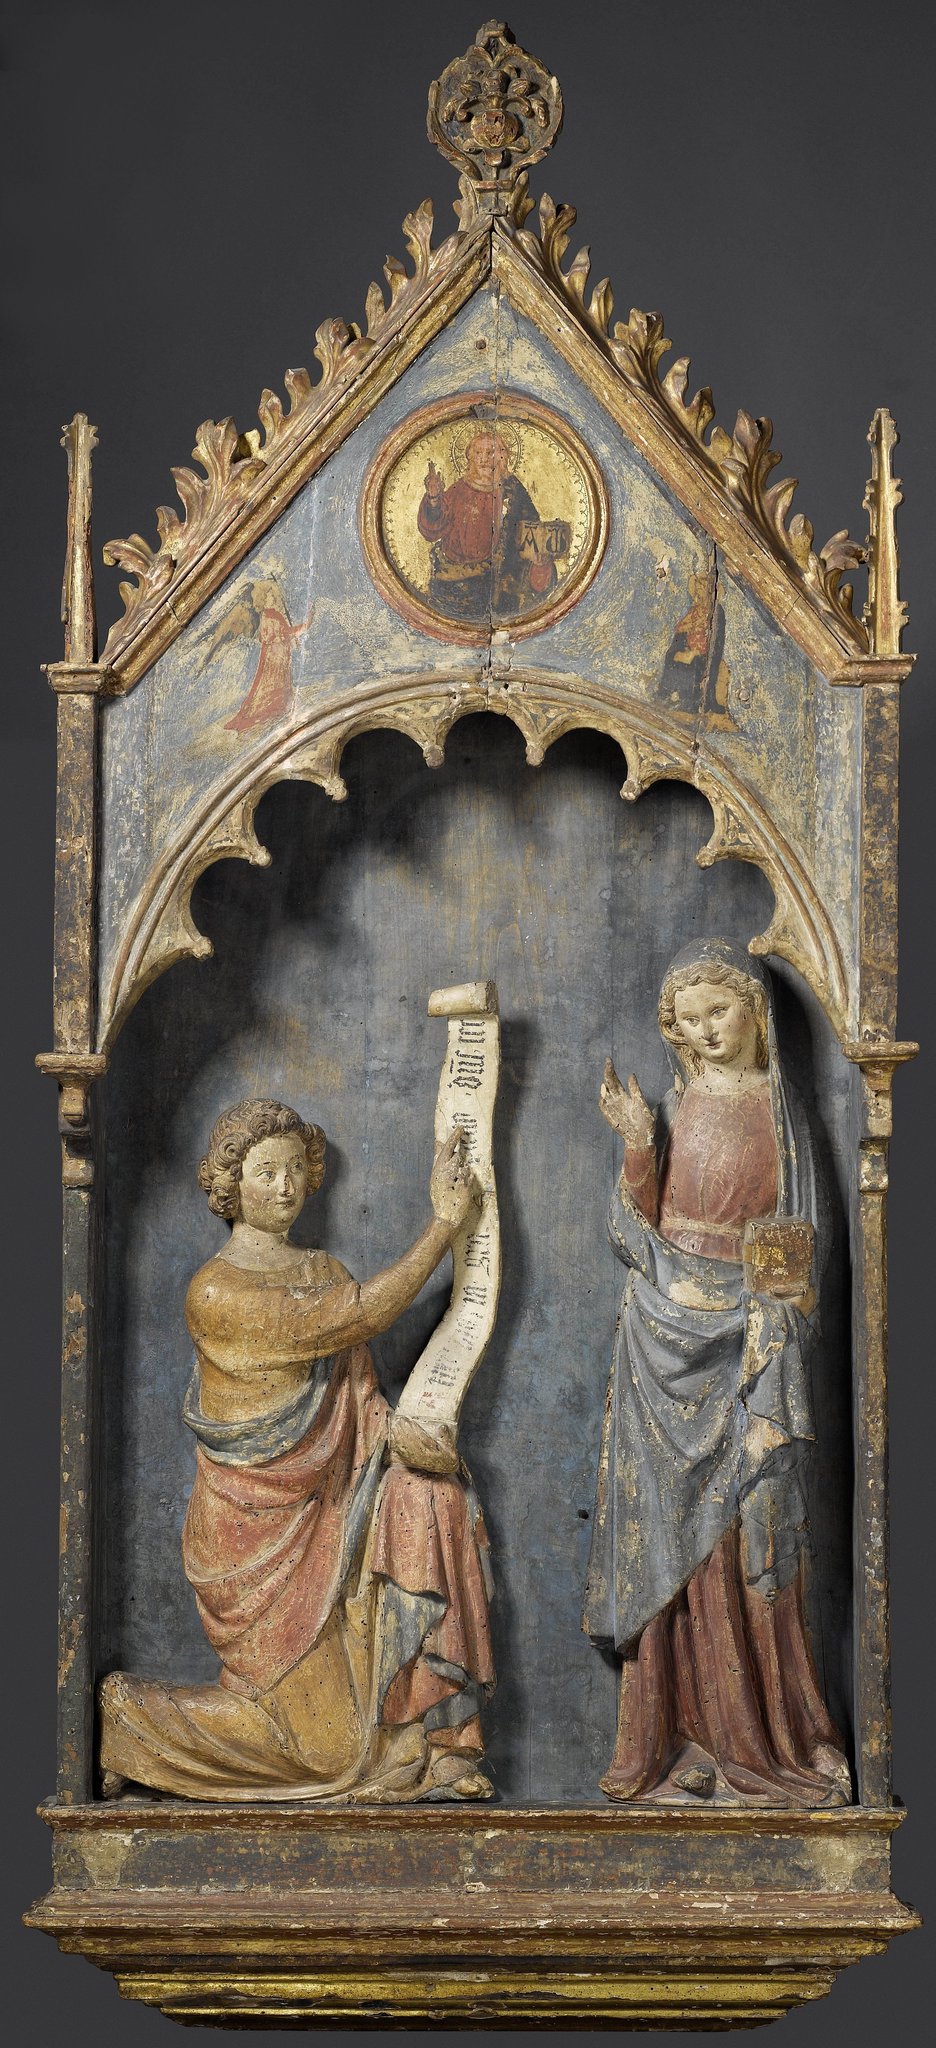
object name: sculpture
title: Maria-boodschap, in architectonische omlijsting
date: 1325-1350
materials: wood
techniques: polychromy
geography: siena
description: The Annunciation. Walnut with polychromy. Siena, c. 1325 - 1350. The canopy is probably a later addition.